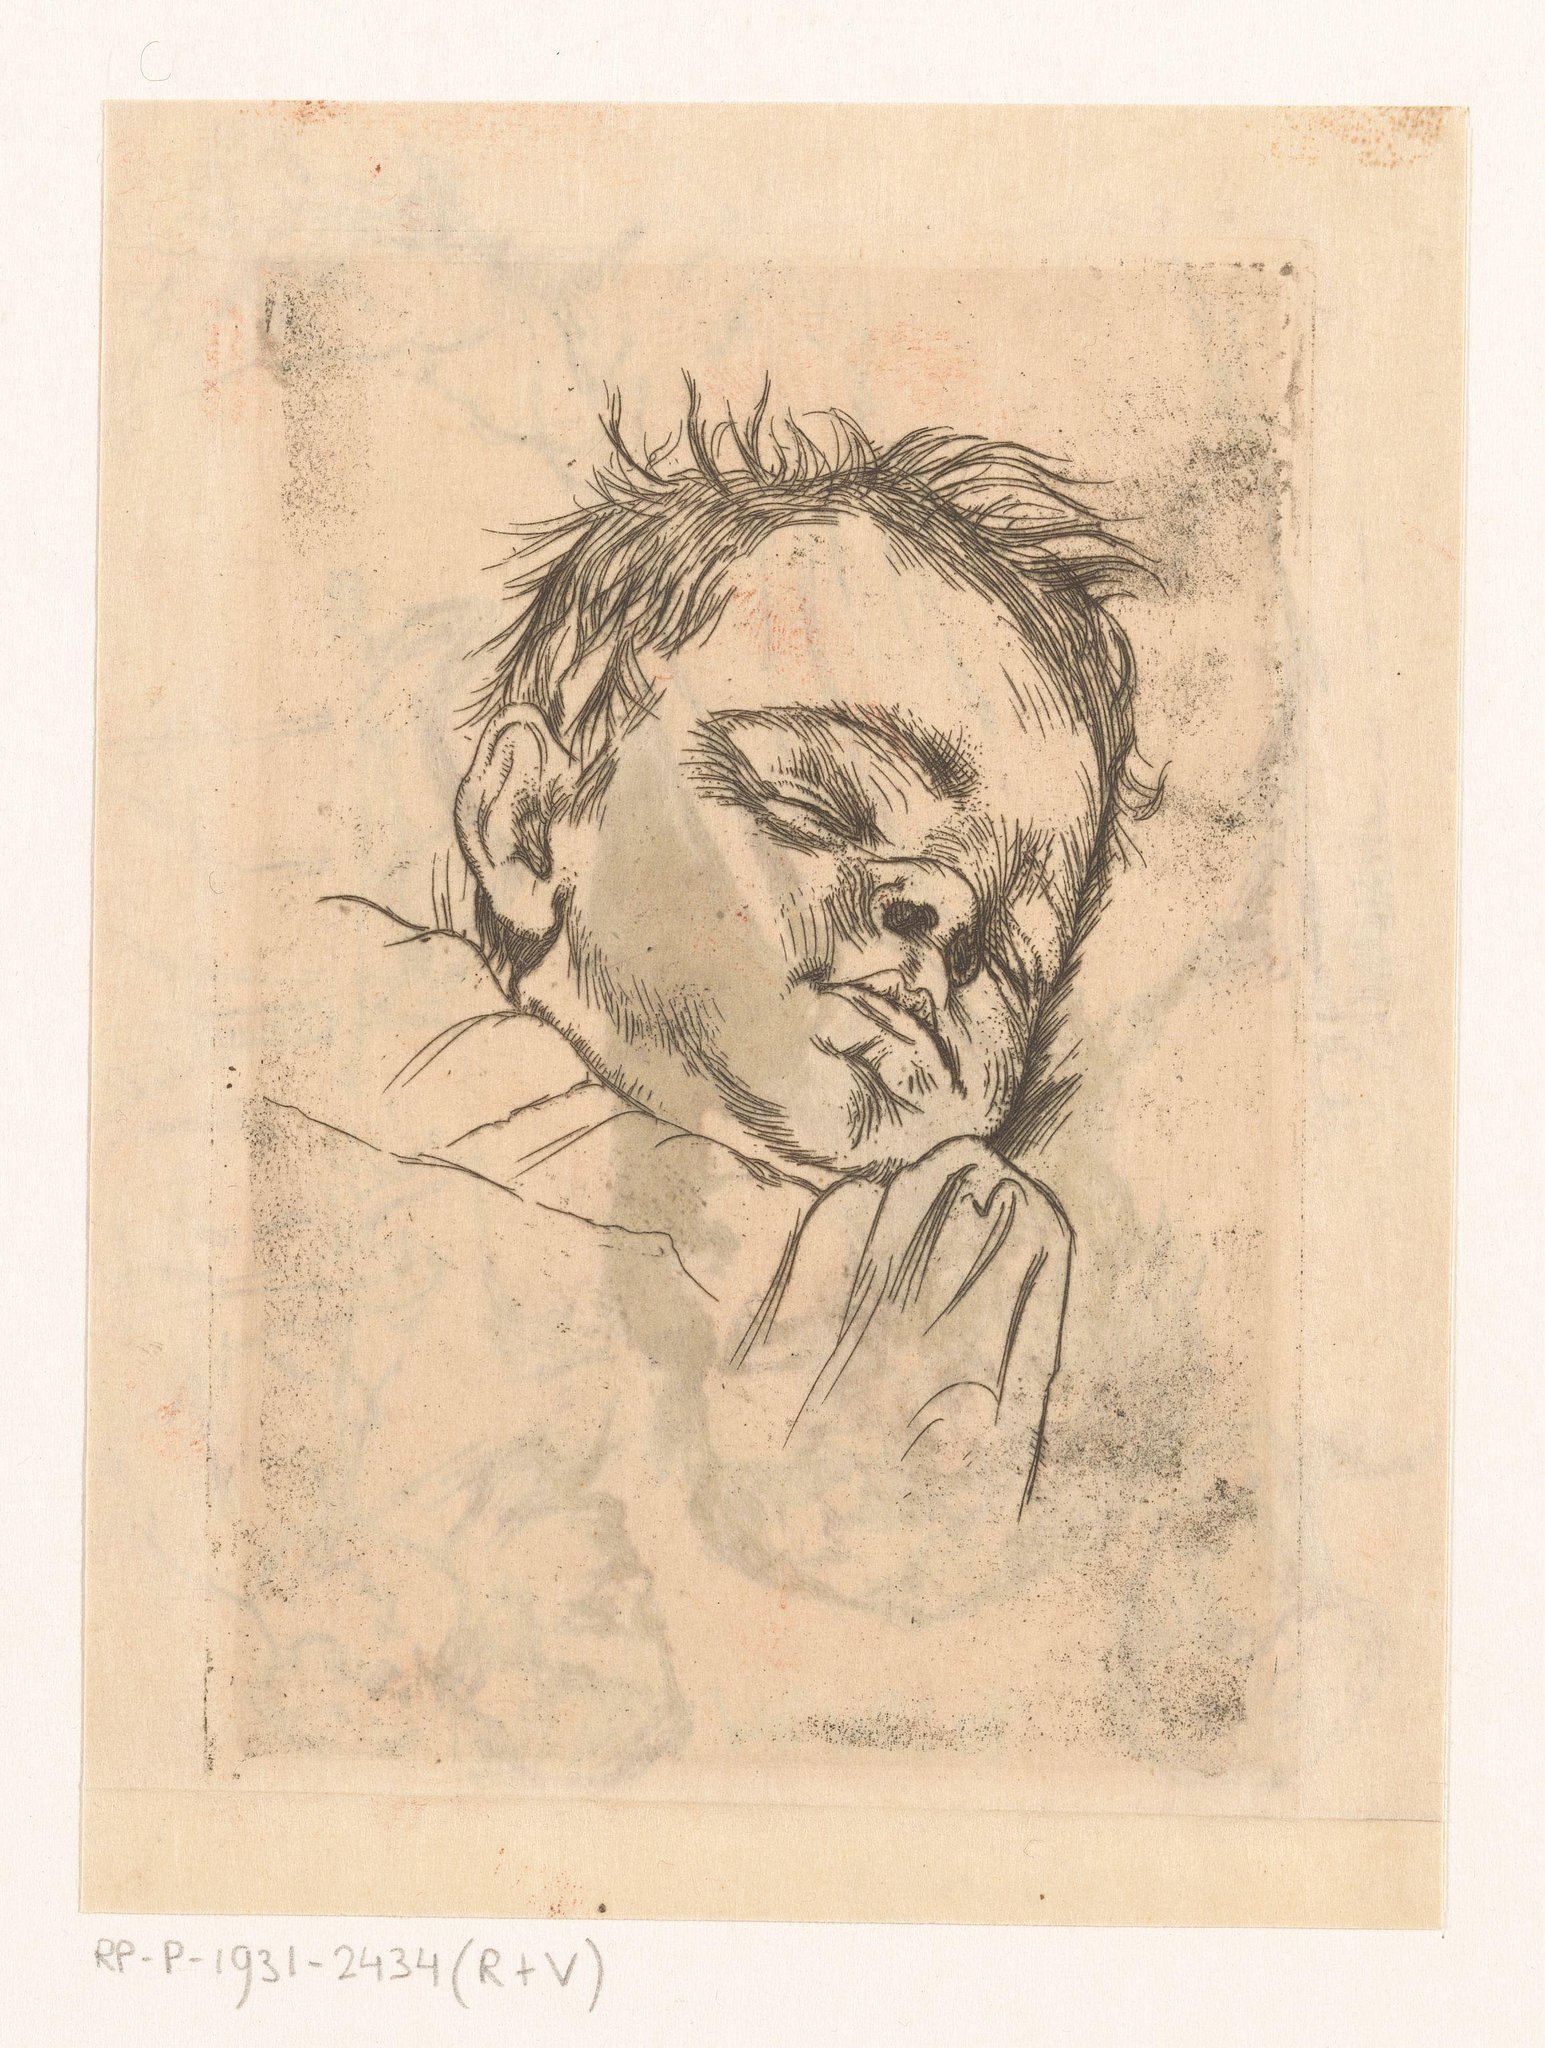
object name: print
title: Slapend kind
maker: johannes löhr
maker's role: print maker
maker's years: 1882-1928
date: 1892-1928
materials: paper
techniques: etching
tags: child, sleeping; unconsciousness